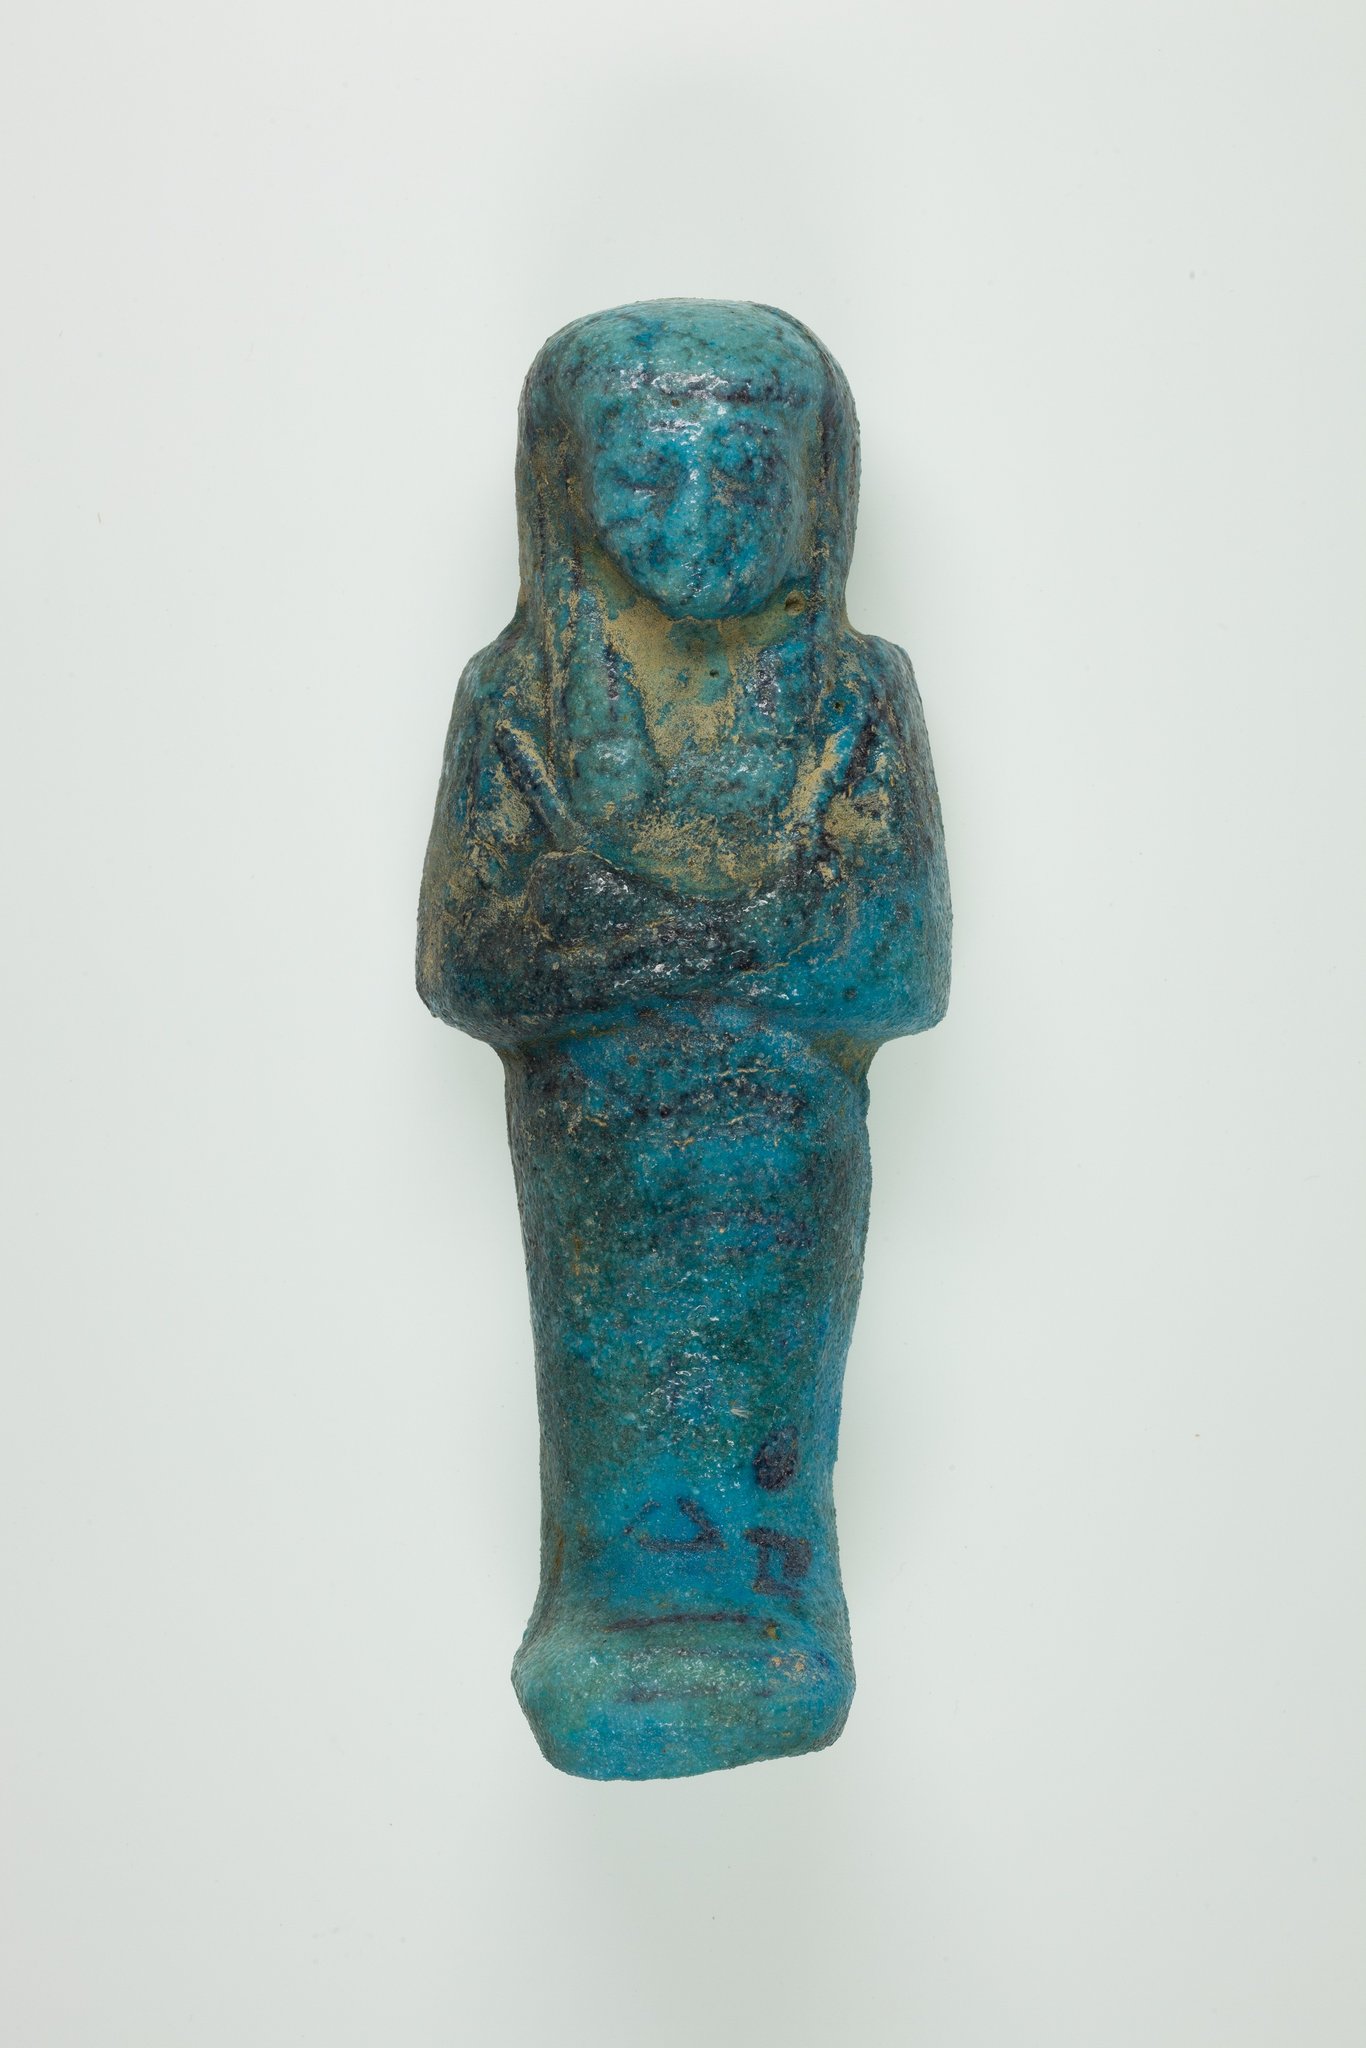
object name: worker shabti, henettawy c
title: Worker Shabti of Henettawy (C), Daughter of Isetemkheb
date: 990-970 BCE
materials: faience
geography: egypt